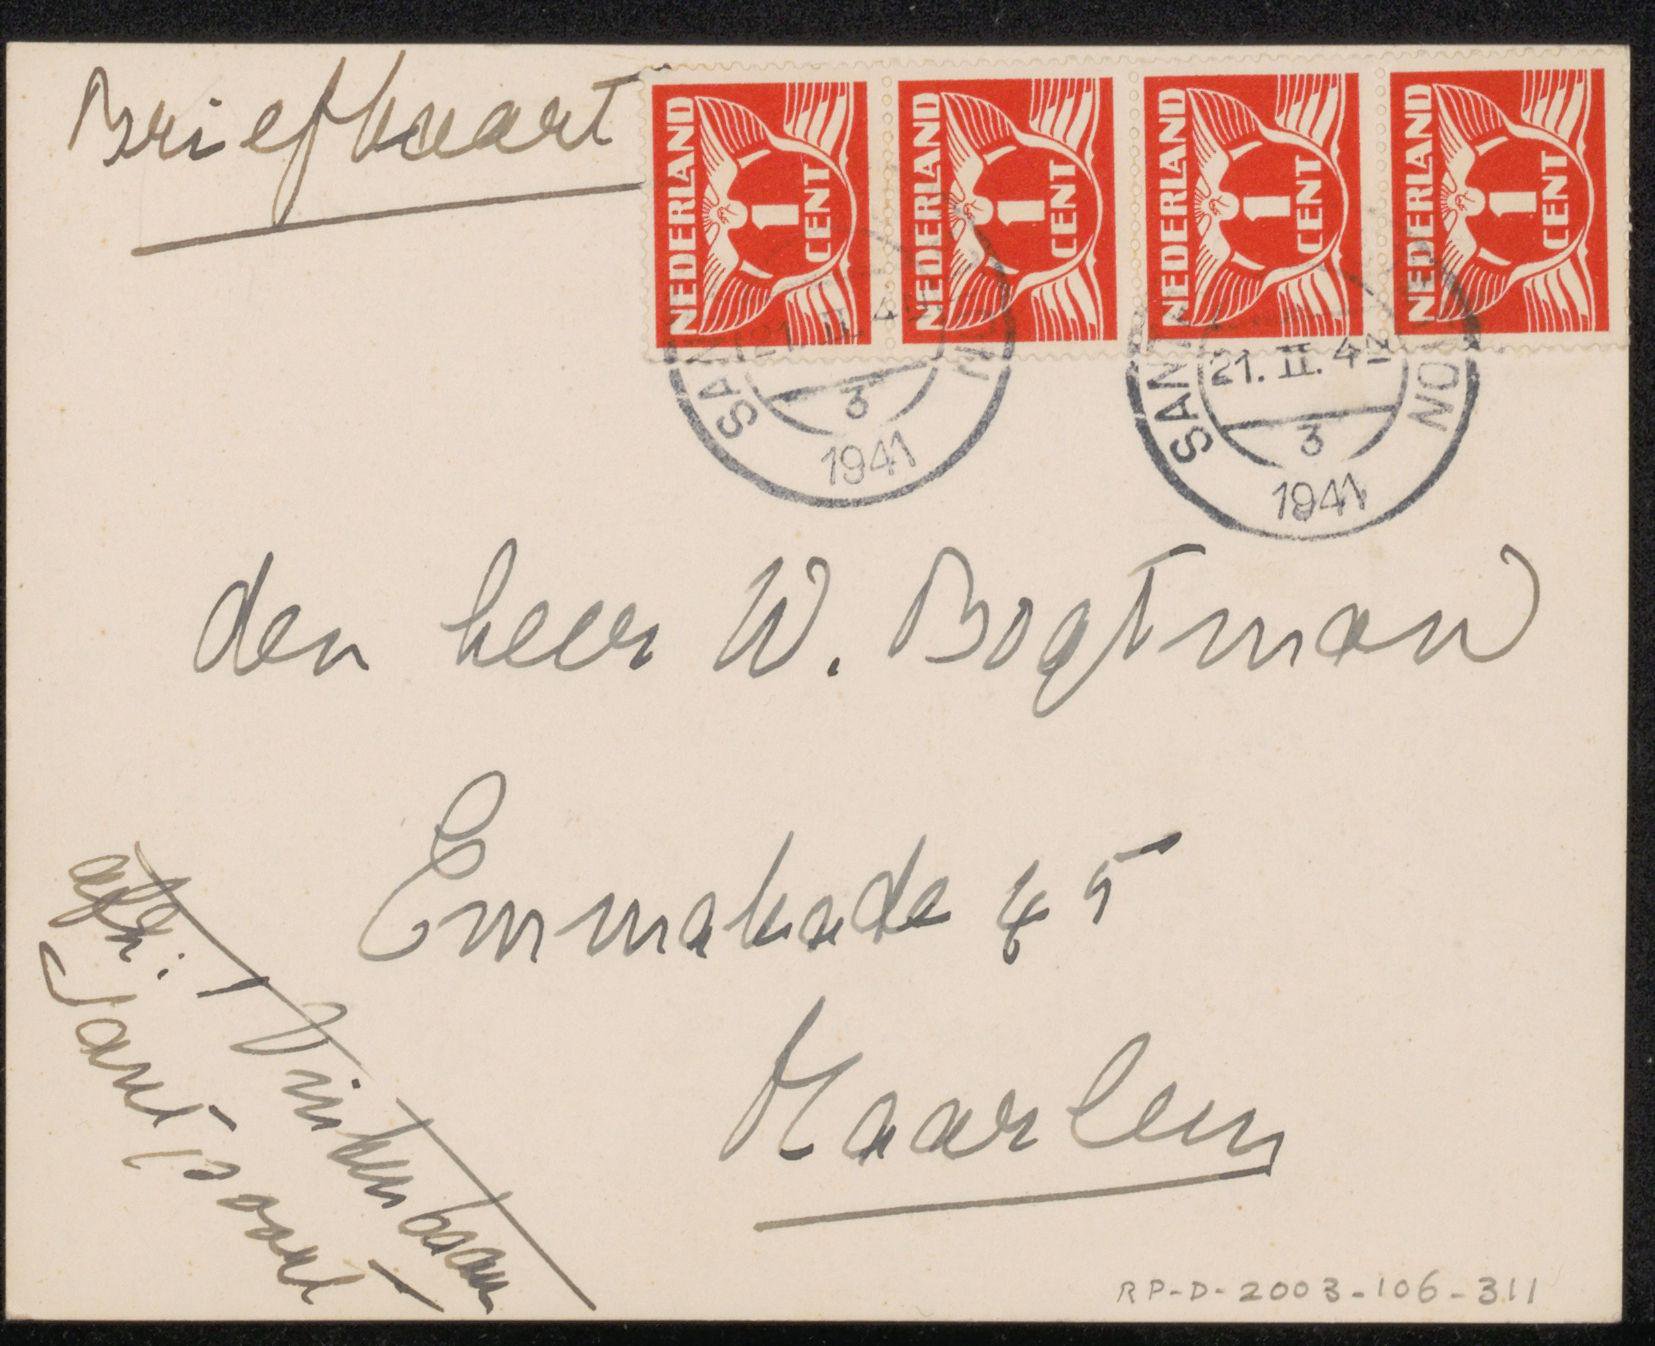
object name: postcard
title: Briefkaart aan Willem Bogtman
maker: henriëtte roland holst-van der schalk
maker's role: dichter, schrijver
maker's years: 1869-1952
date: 1941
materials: ink, paper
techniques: pen, writing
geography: santpoort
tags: haarlem, willem bogtman, richard nicolaüs roland holst, the graphic arts, historical persons (portraits and scenes from the life)